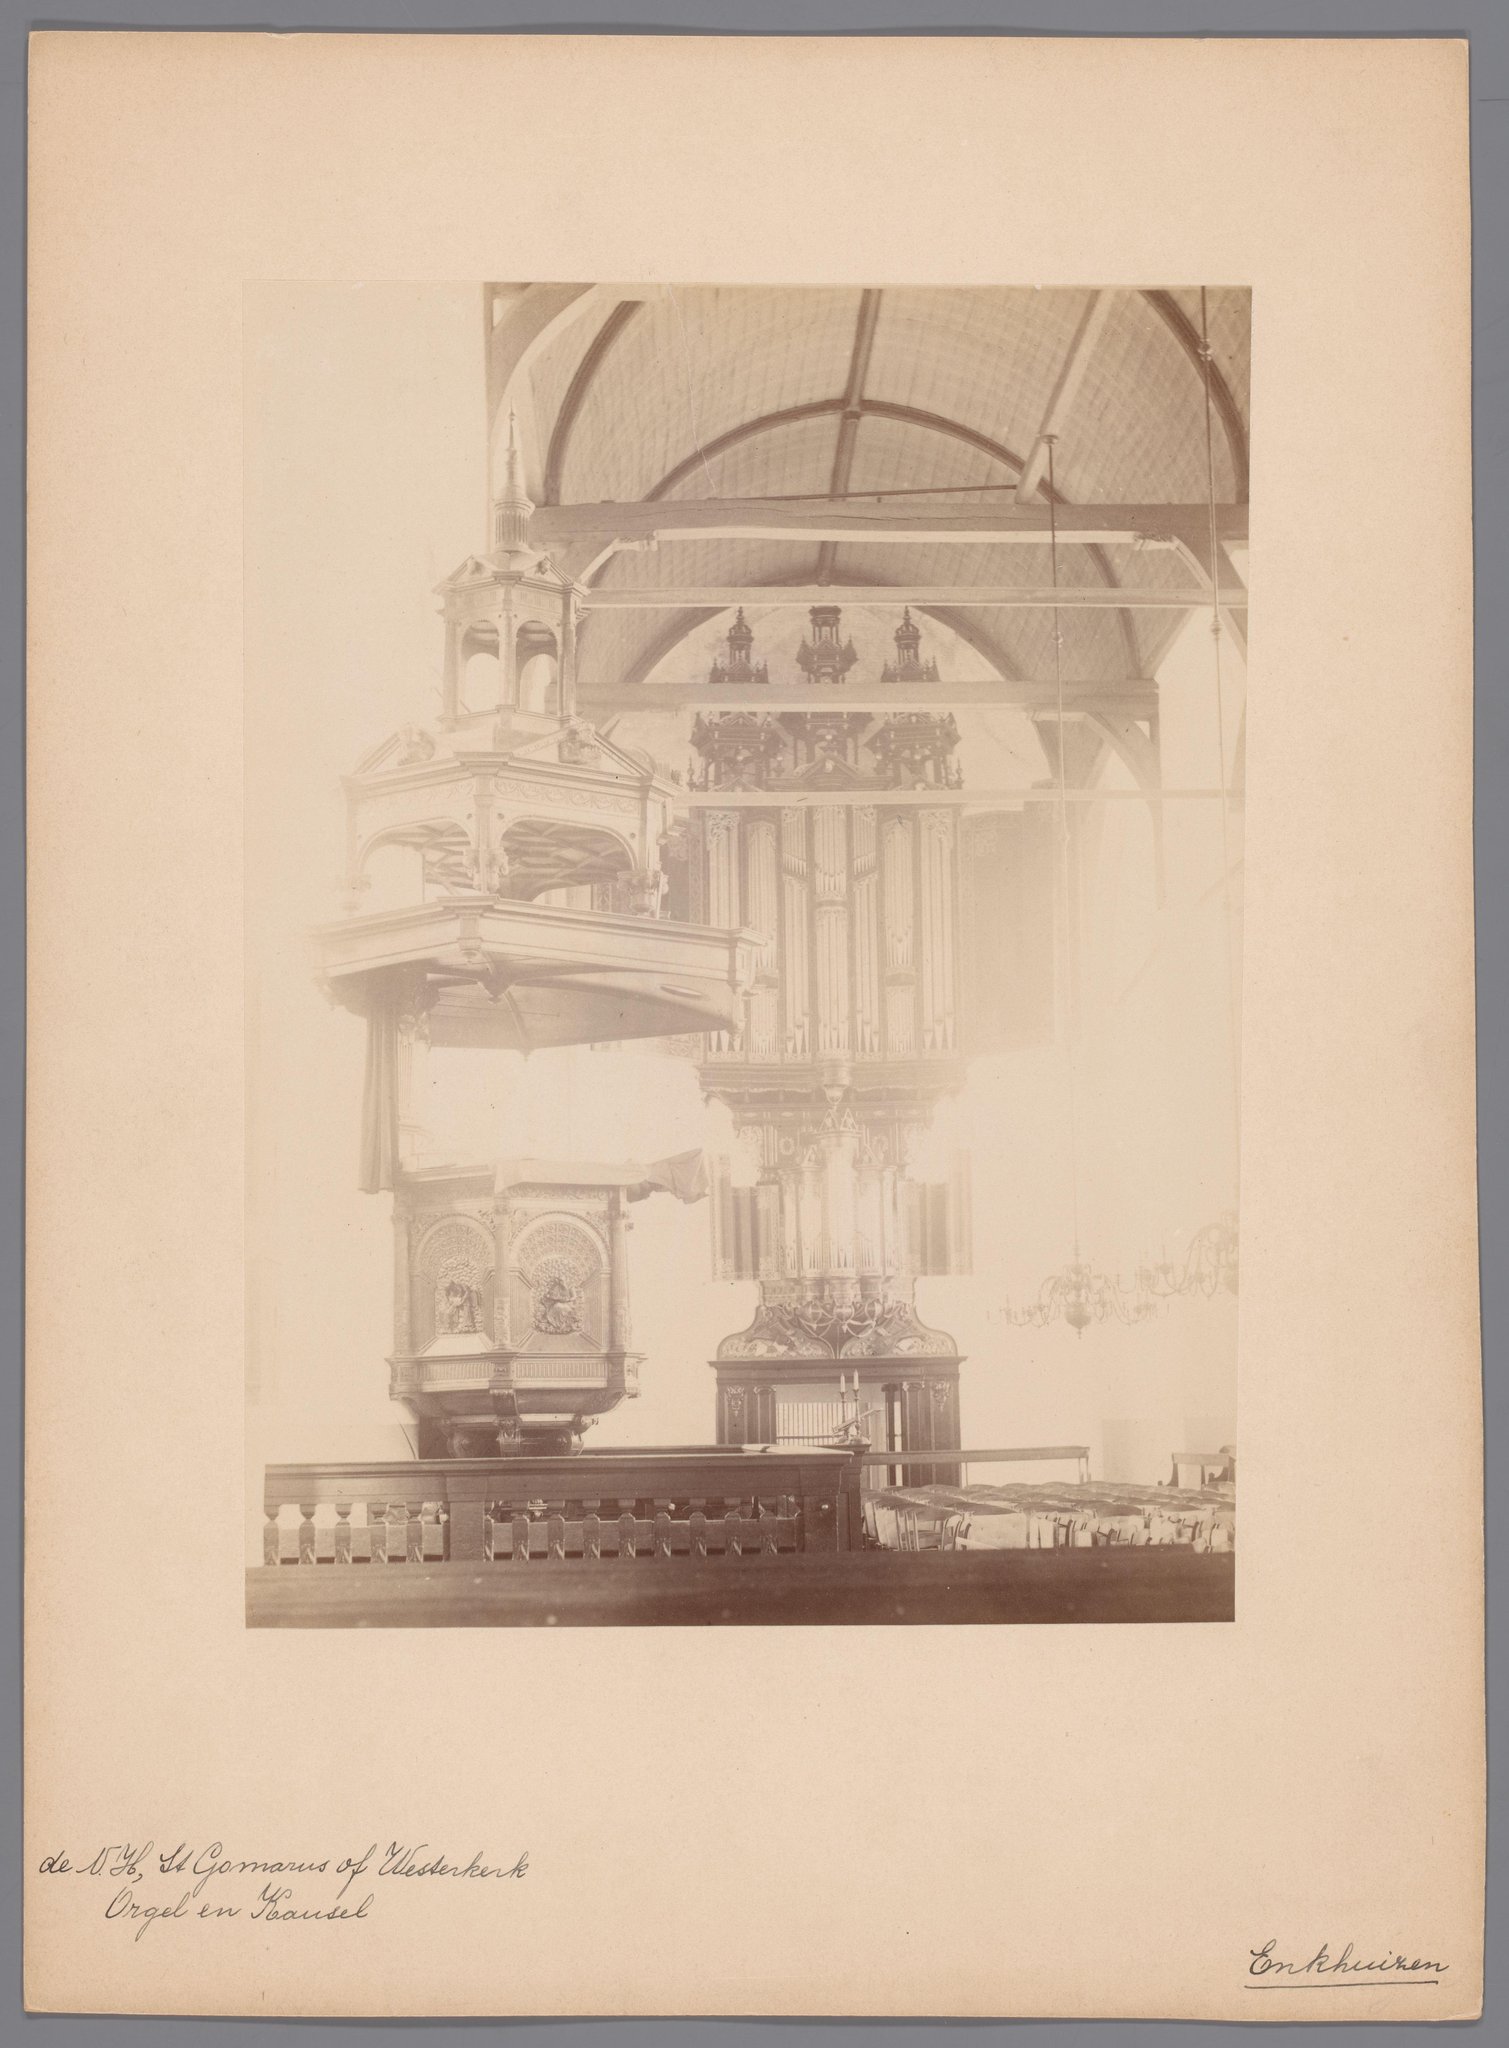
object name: photograph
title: Orgel en kansel van de Westerkerk te Enkhuizen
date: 1880-1895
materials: cardboard, photographic support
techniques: albumen print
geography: westerkerk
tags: organ, interior of church, pulpit, ambo, chancel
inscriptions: annotation: ‘de N.H, st. Gomarus of Westerkerk/ Orgel en Kansel/ Enkhuizen’, annotation: ‘orgel en kansel/ Westerkerk te Enkhuizen’